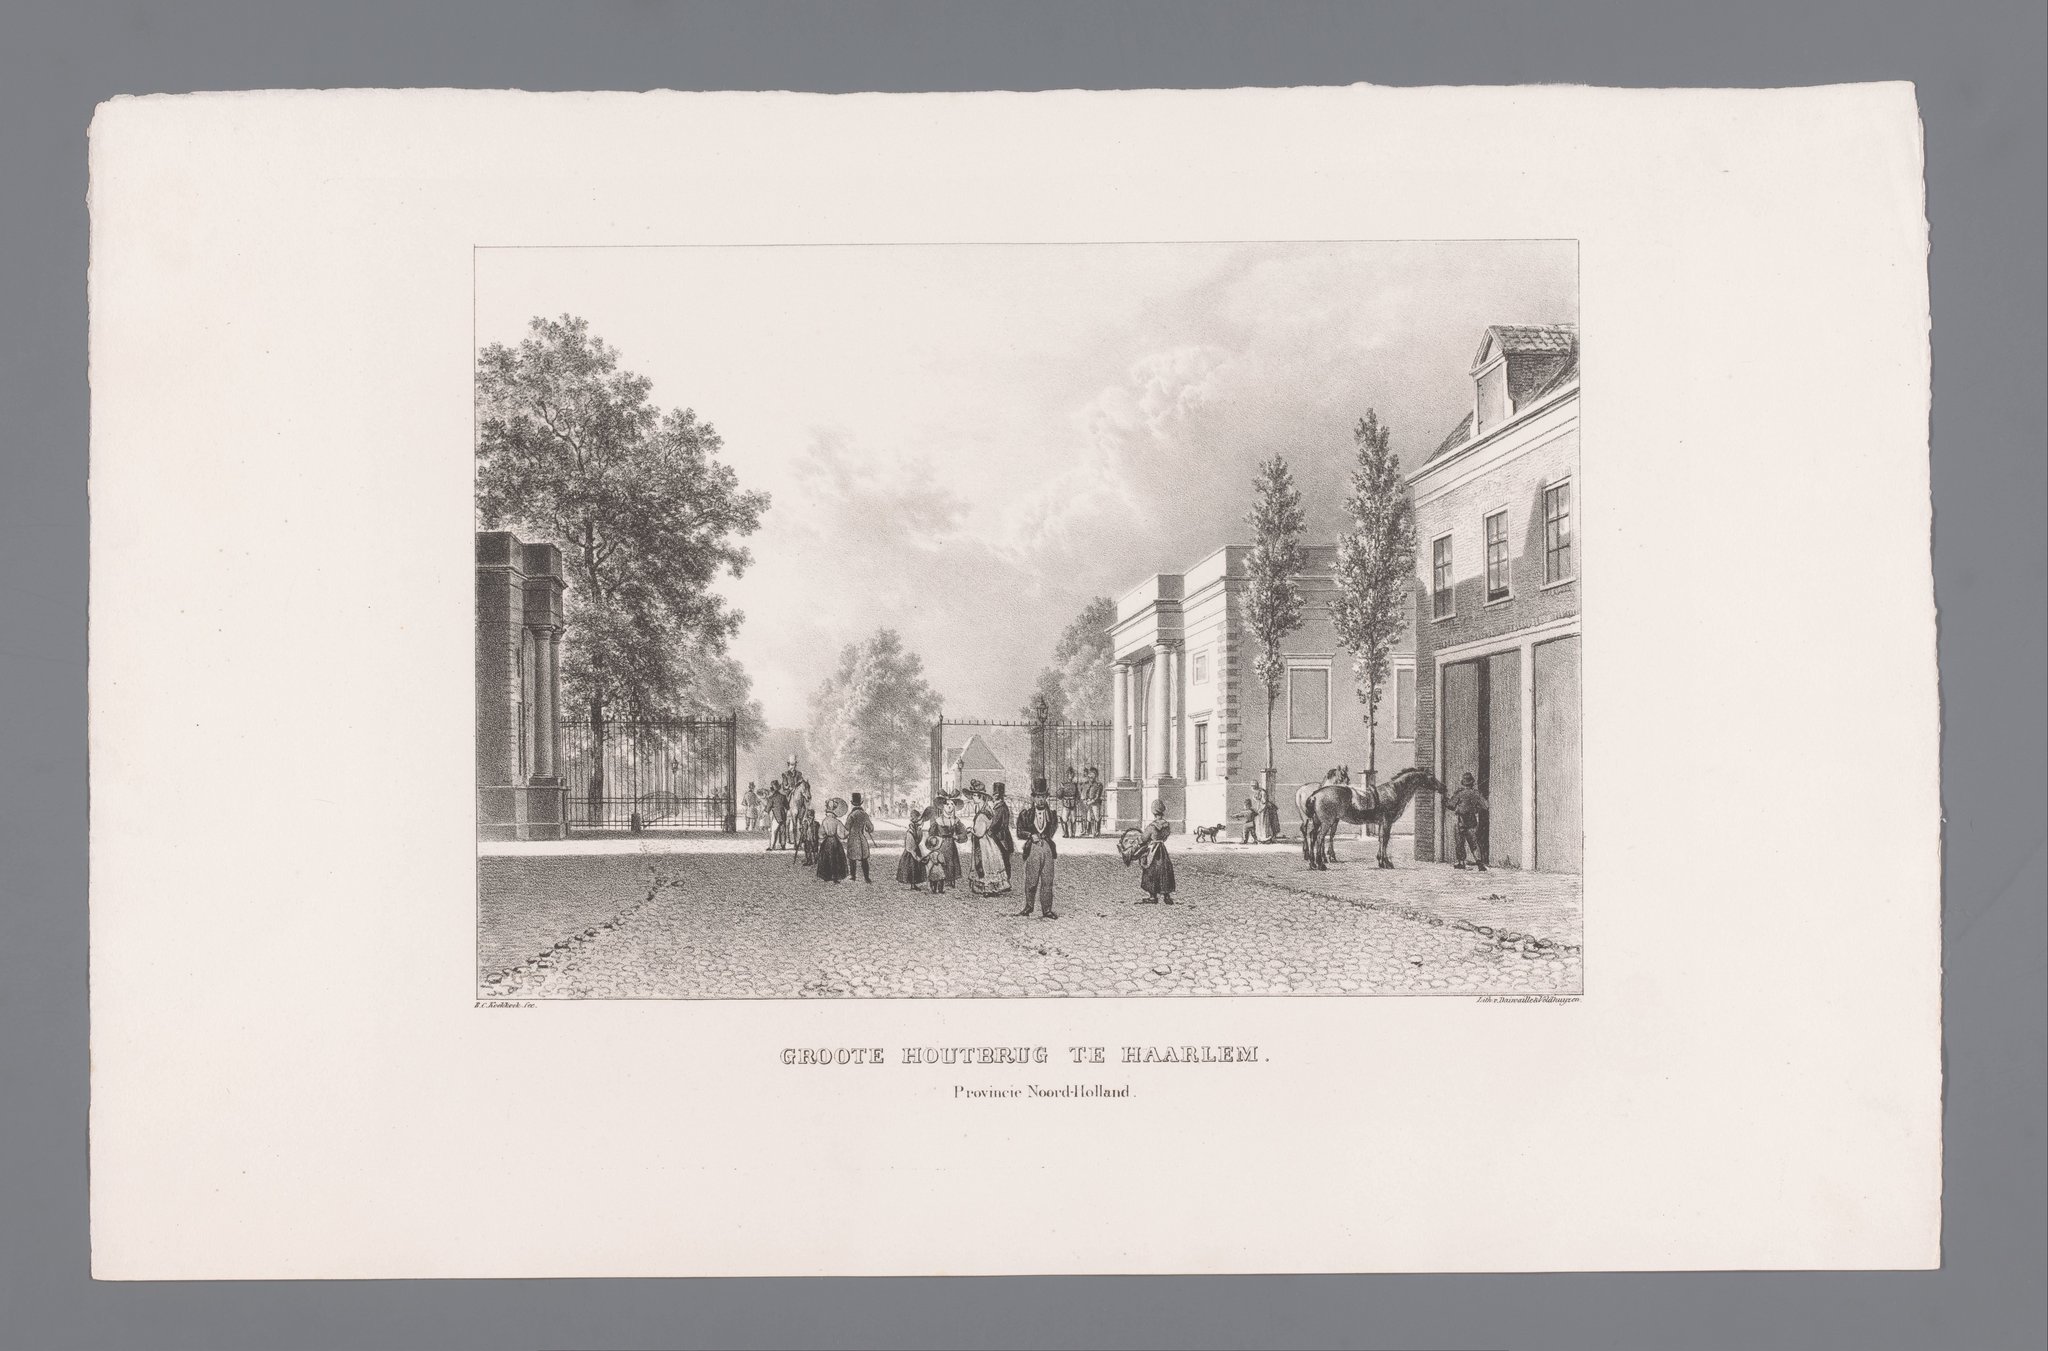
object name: print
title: Vues Pittoresques du Royaume des Pays-Bas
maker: barend cornelis koekkoek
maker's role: draughtsman, painter, print maker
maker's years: 1803-1862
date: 1831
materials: paper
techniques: lithograph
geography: amsterdam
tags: toll gate, public road in village (+ city(-scape) with figures, staffage)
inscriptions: collector's mark: Lugt 12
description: Links en rechts van de poort commiezenhuizen waar door ambtenaren tol werd geheven bij het binnengaan van de stad. Op straat lopen figuren. Deze prent maakt deel uit van een omslag met negen prenten.